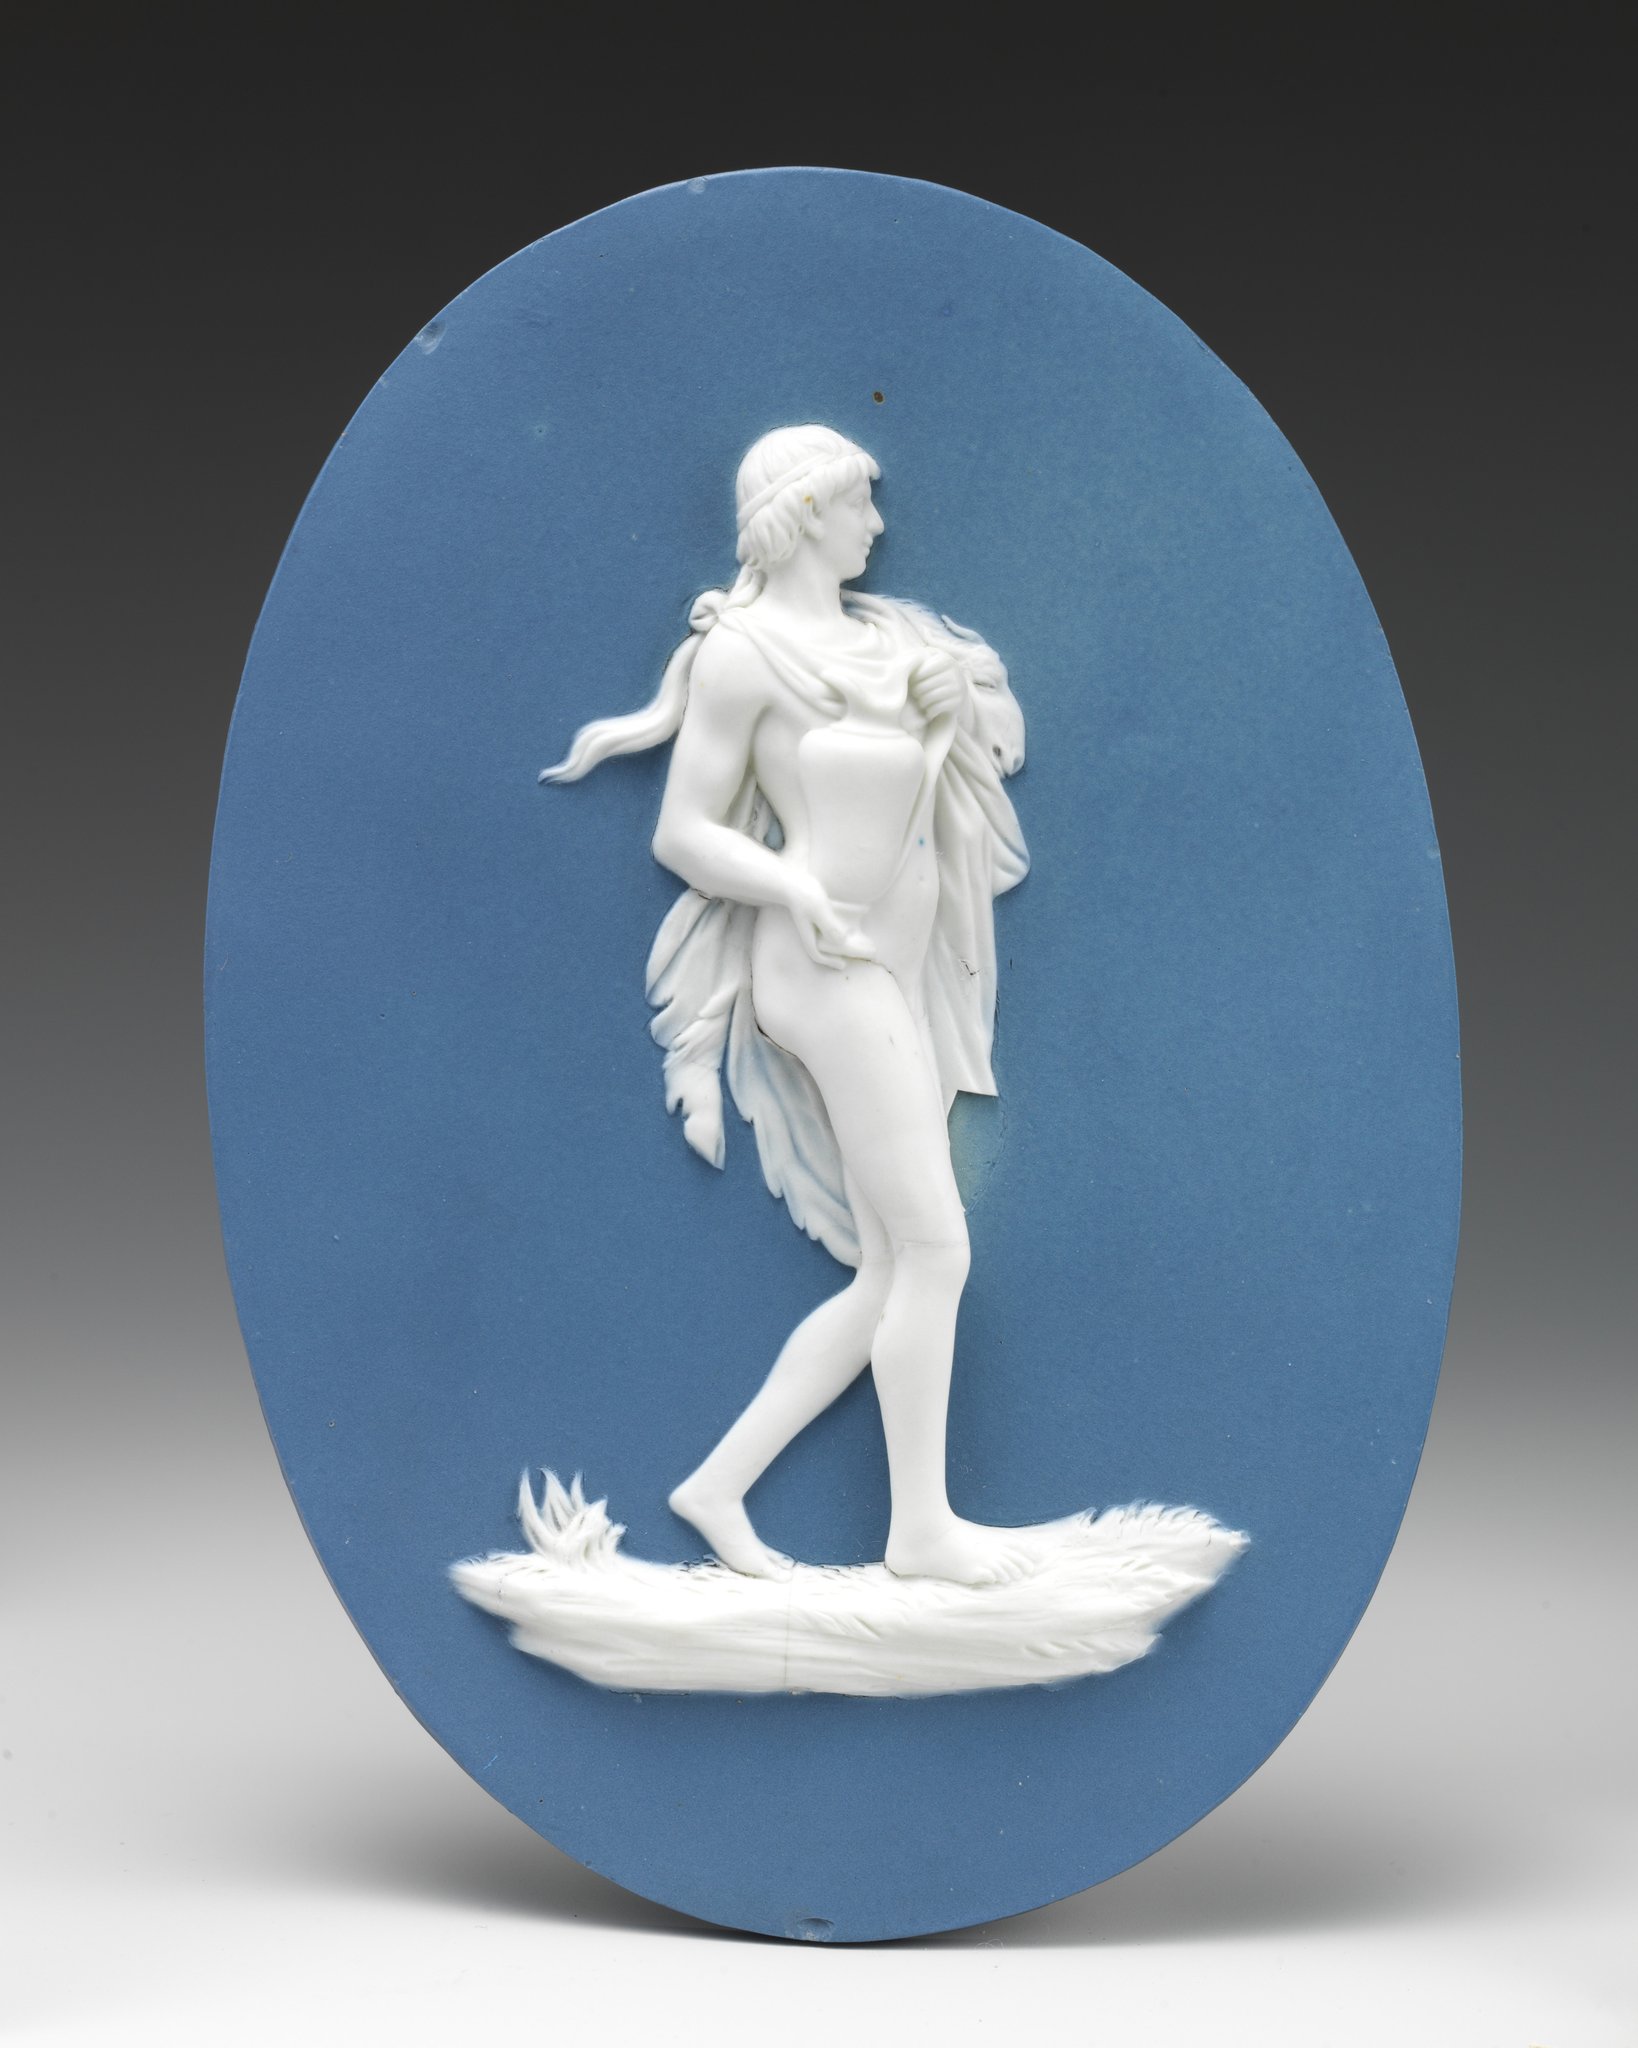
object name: cameo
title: Bacchic youth carrying a wine jug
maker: wedgwood and bentley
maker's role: maker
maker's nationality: british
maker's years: 1769-1780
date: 1769-1780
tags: men